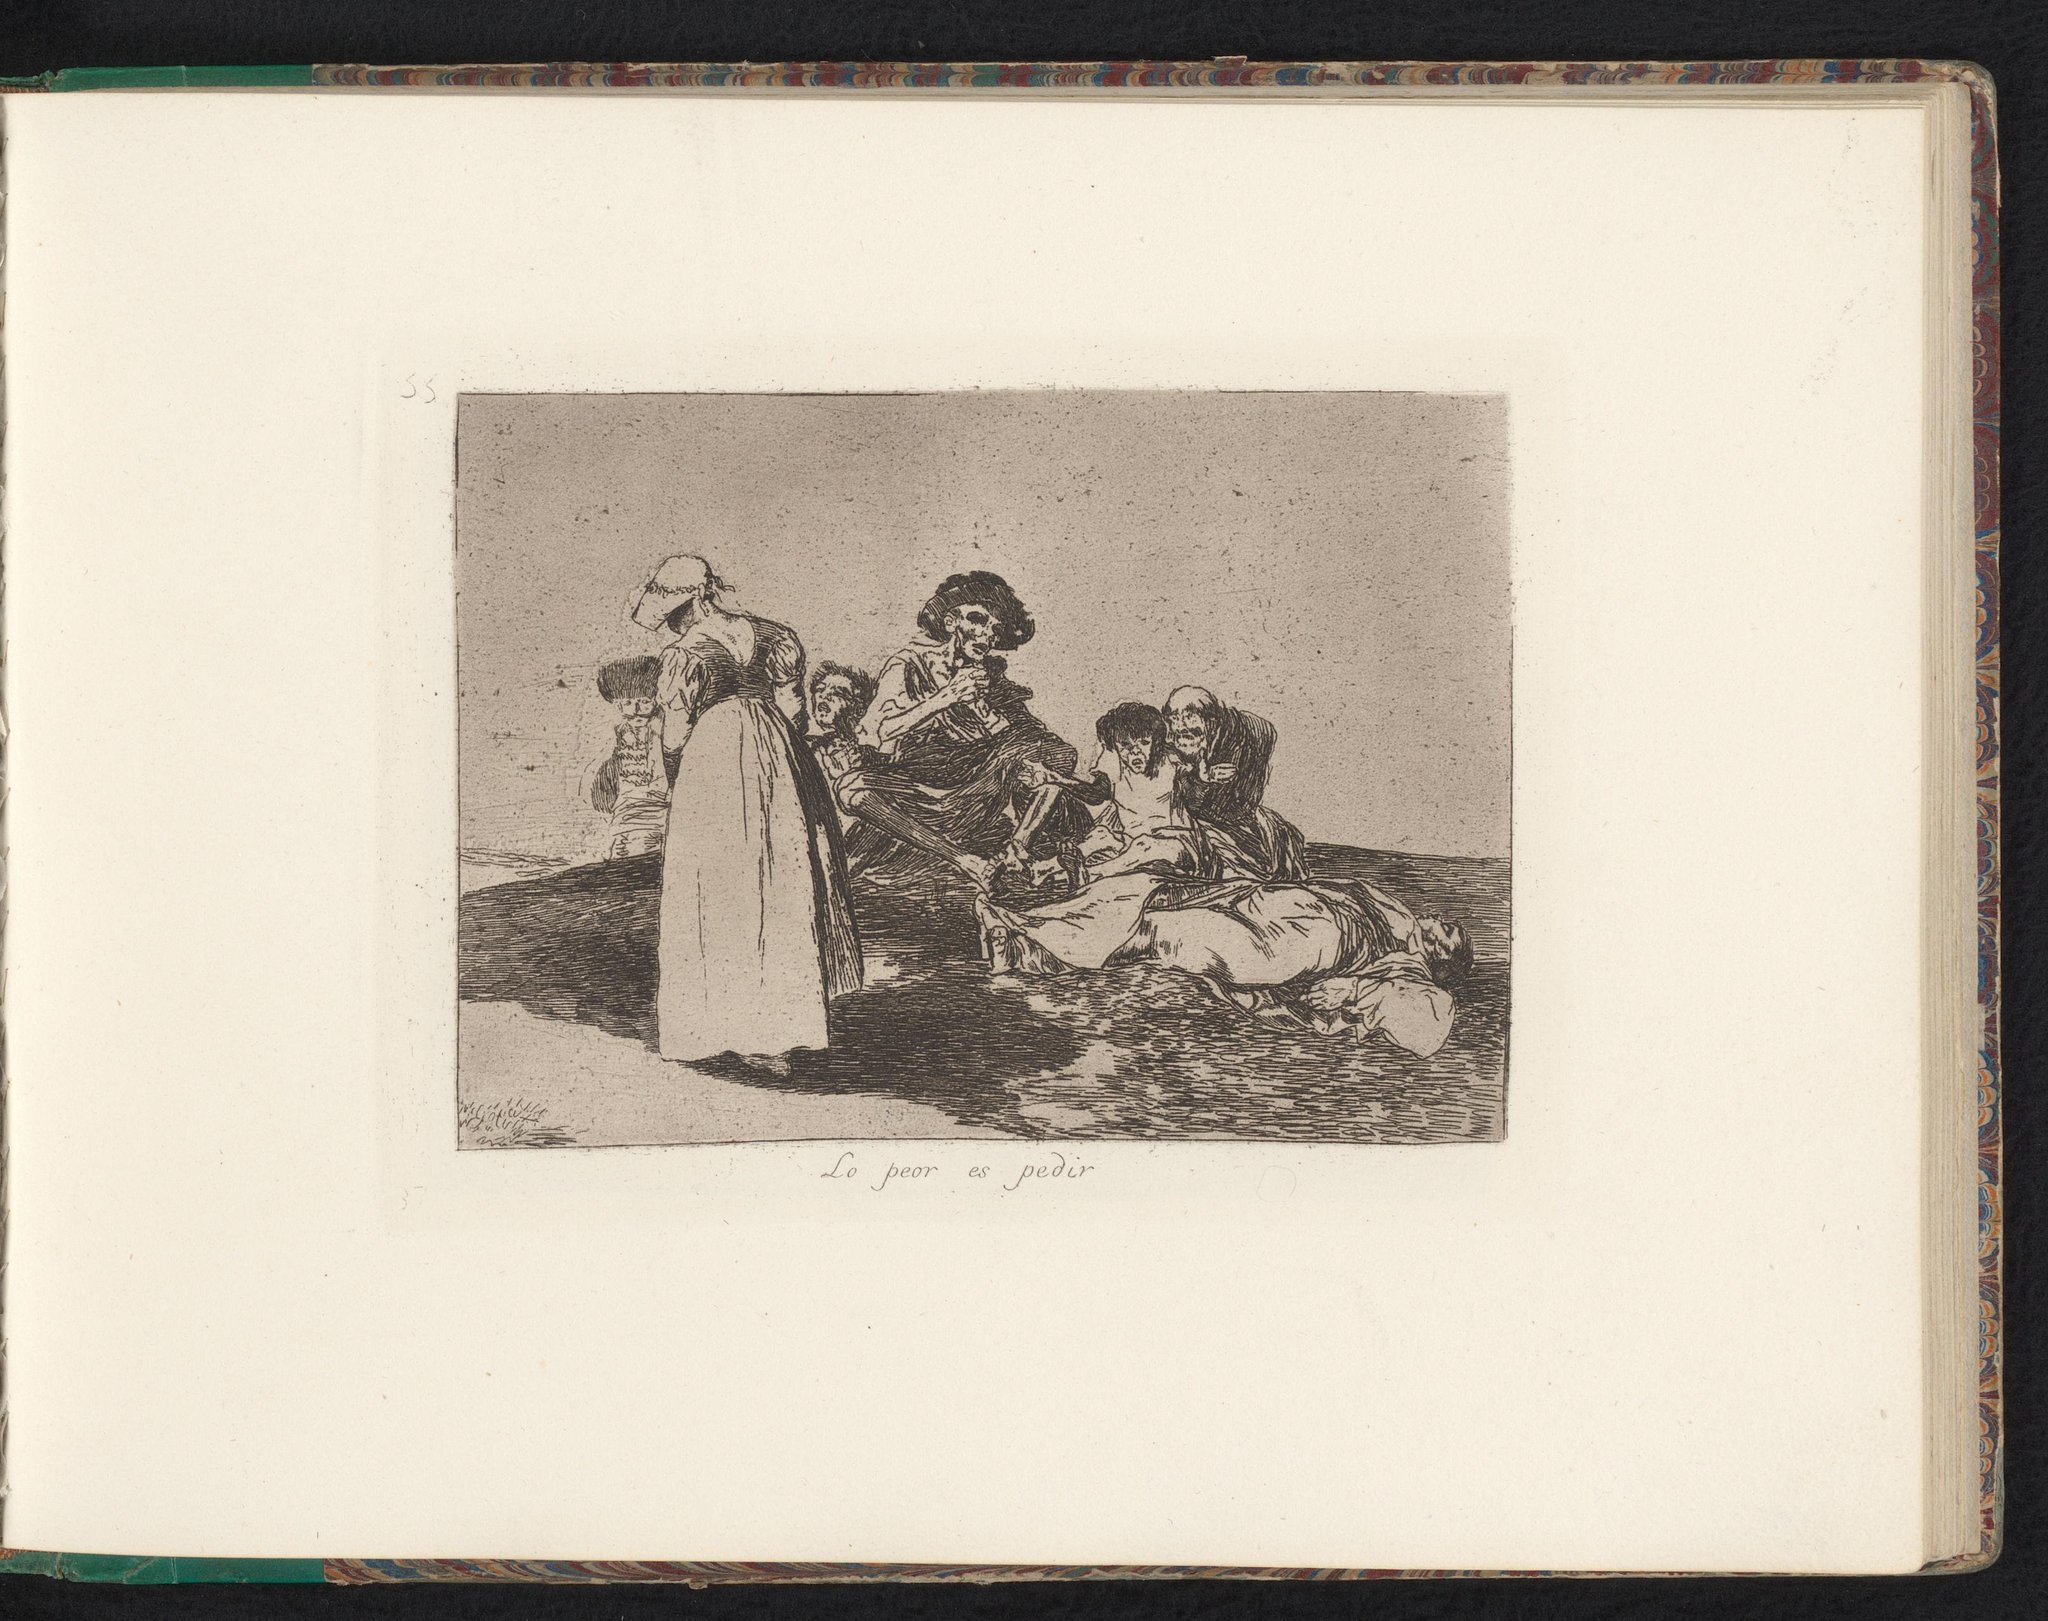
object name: print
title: Gruwelen van de oorlog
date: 1810-1820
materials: paper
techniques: aquatint, etching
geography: madrid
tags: horrors of war, beggar, spain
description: Deze prent maakt deel uit van een album.